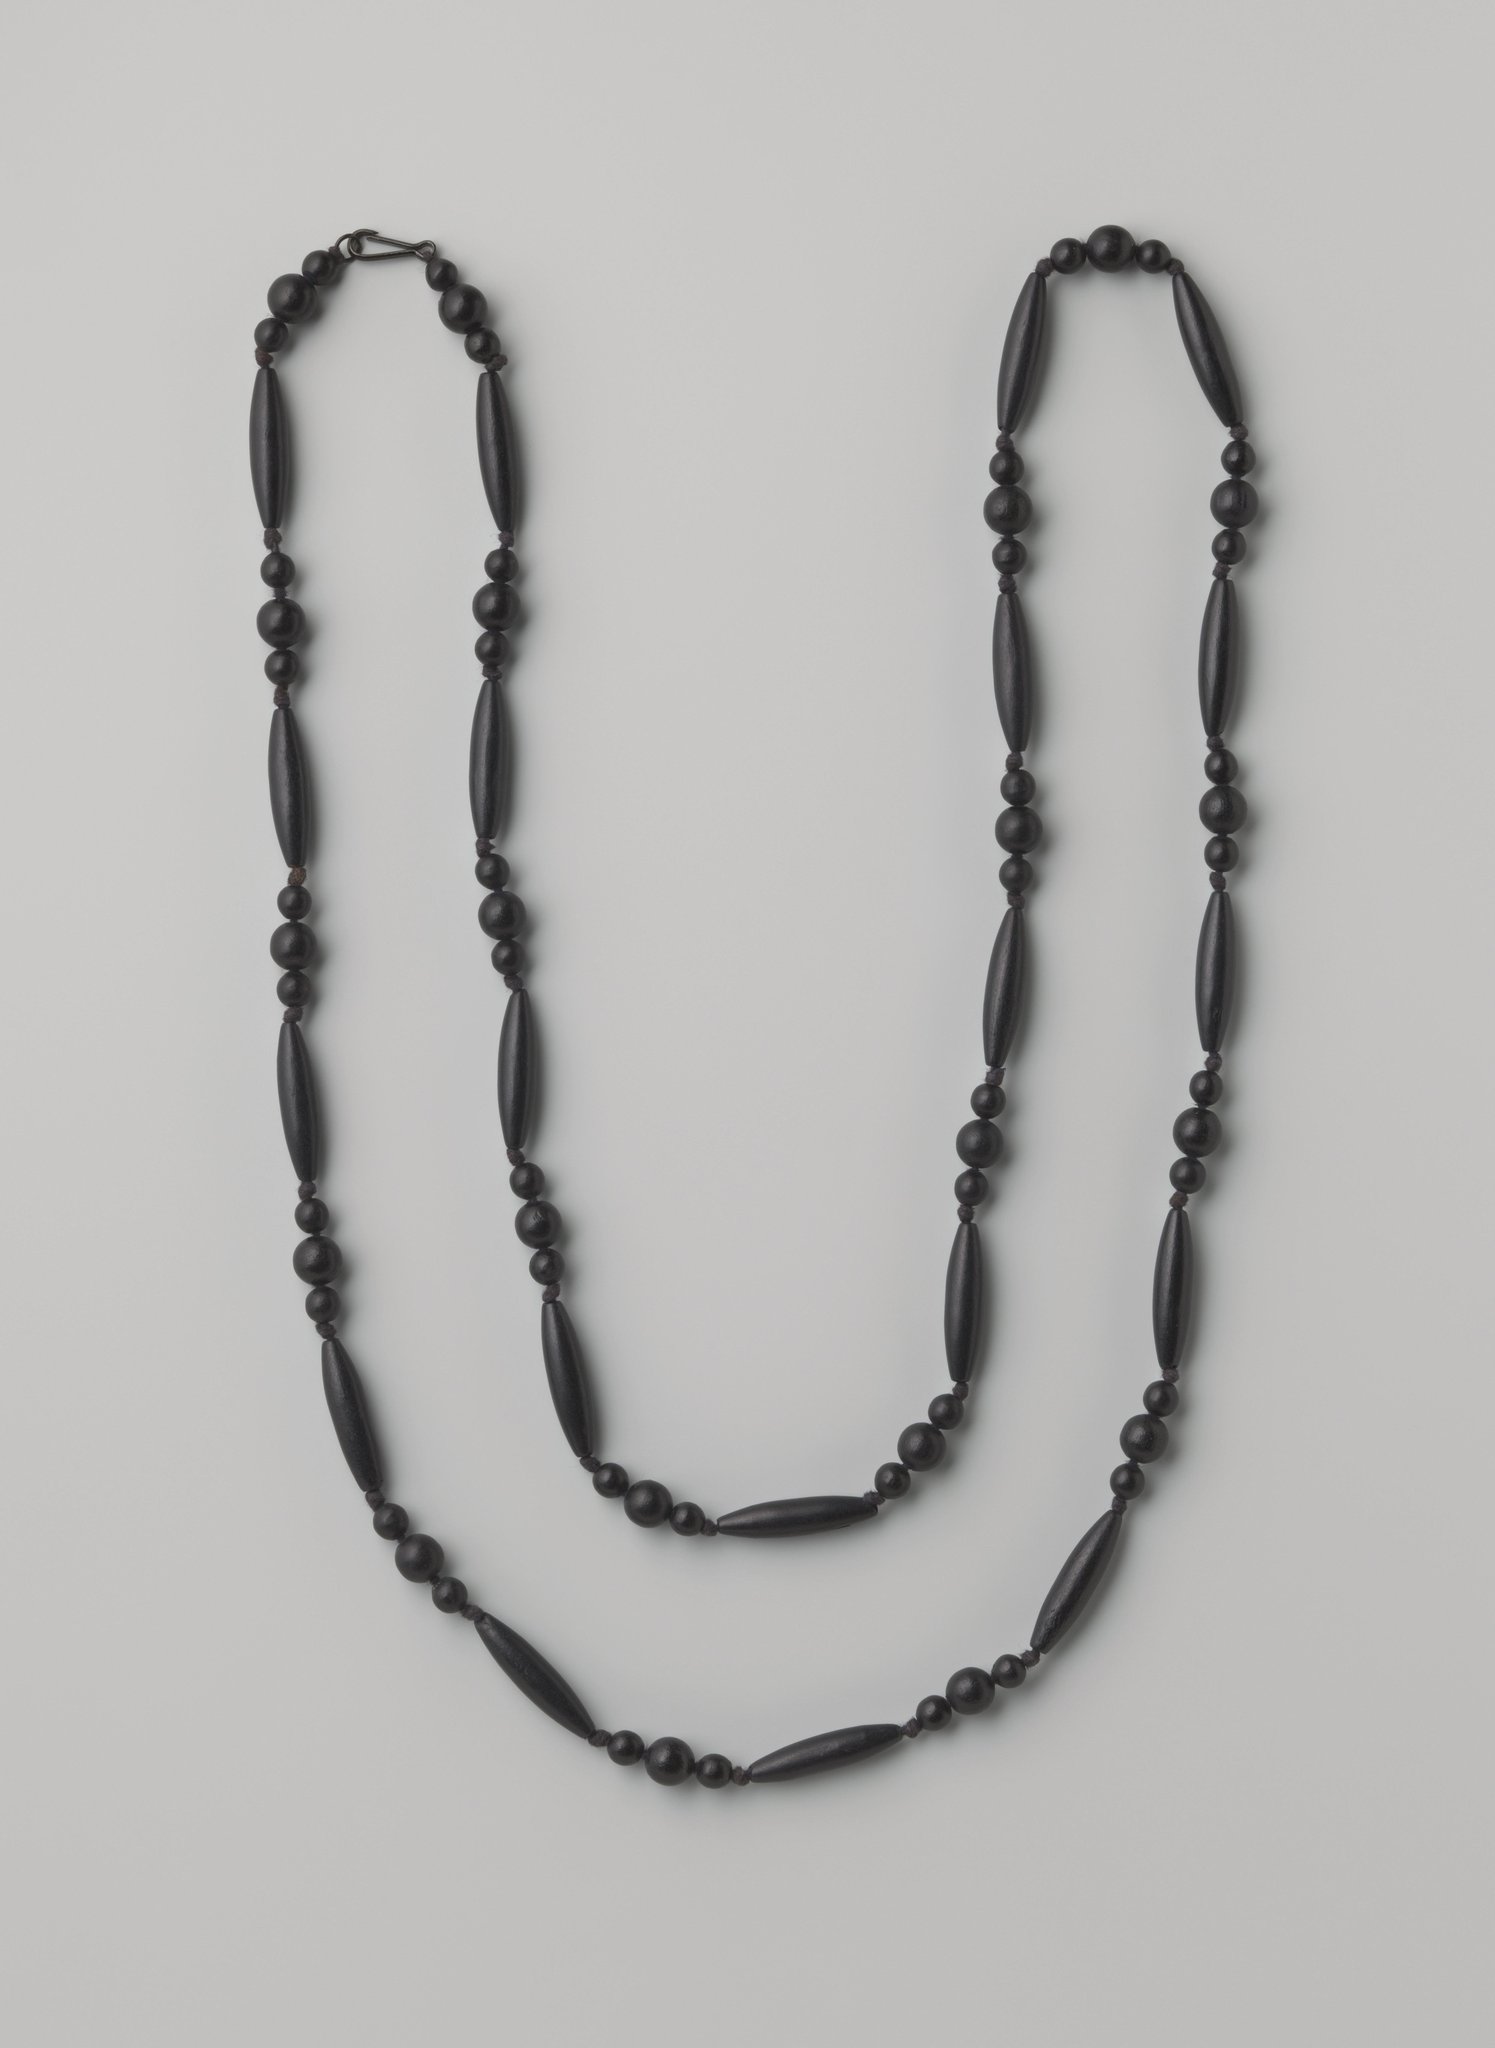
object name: necklace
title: Rouwcollier van zwarte kralen van hout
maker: Anonymous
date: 1880-1900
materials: metal, wood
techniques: sewing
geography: europe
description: Rouwcollier van zwarte kralen van hout. Het collier bestaat uit twintig langgerekte kralen die steeds worden afgewisseld met drie kralen in bolvorm, waarvan telkens de middelste het grootst is. Het collier sluit met een haak en oog.